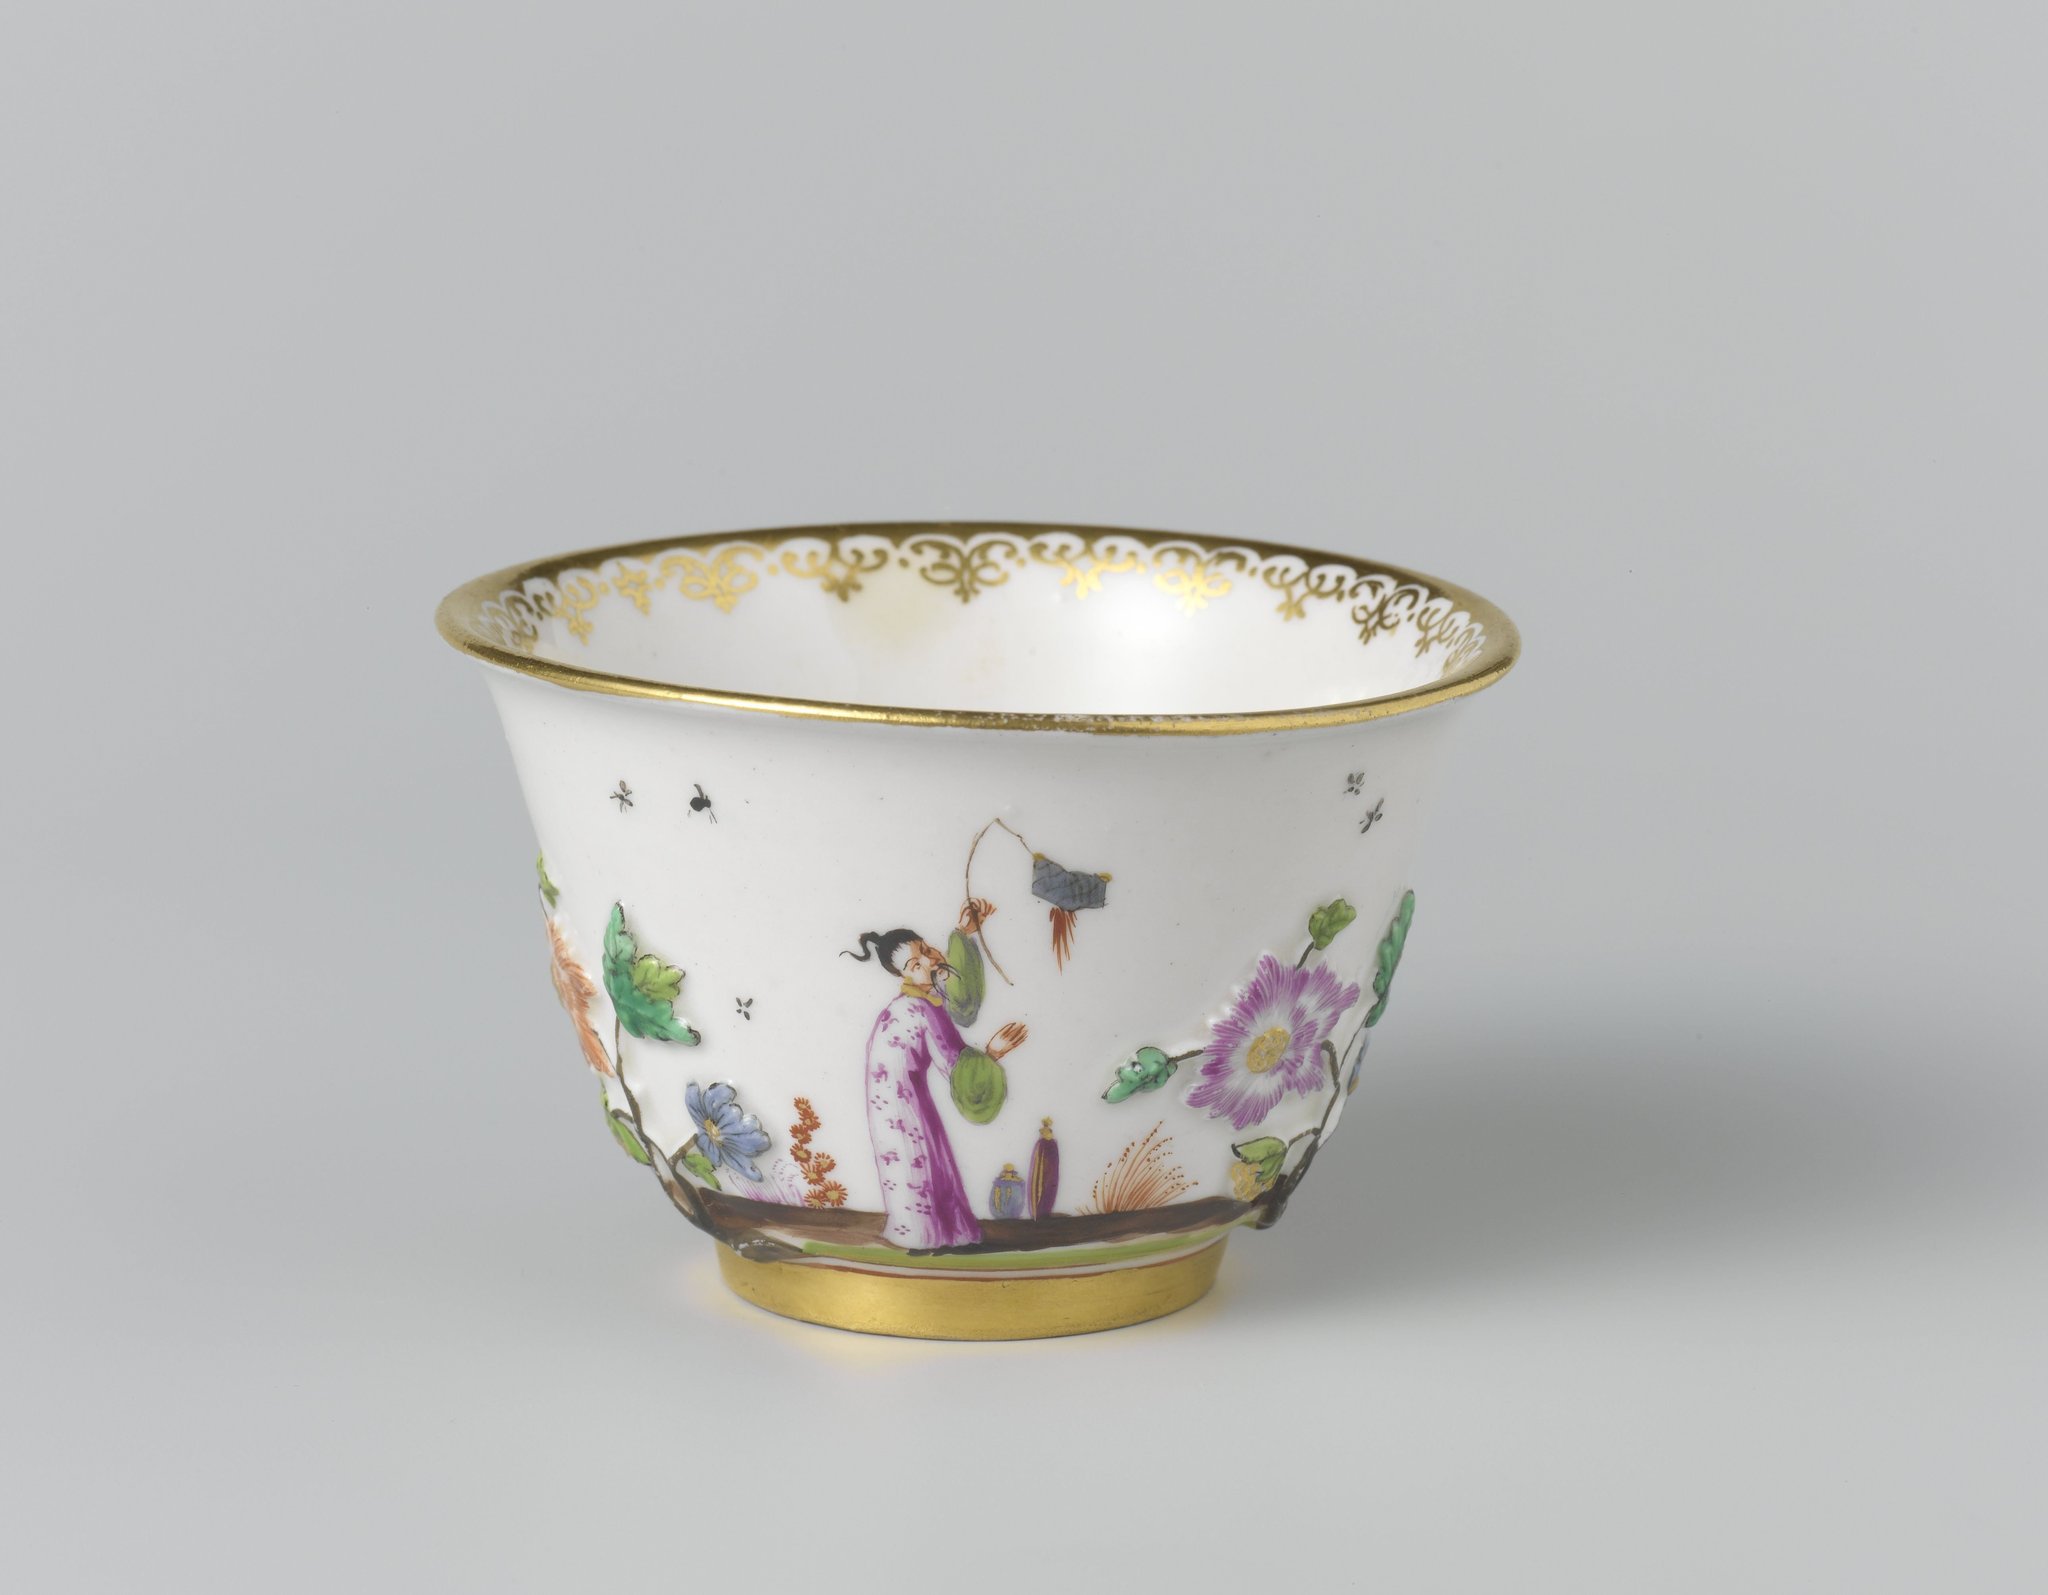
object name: cup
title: Cup and saucer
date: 1725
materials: porcelain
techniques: painted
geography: meissen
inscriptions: mark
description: Meissener Porzellan Manufaktur Meissen, c. 1725 hard-paste porcelain